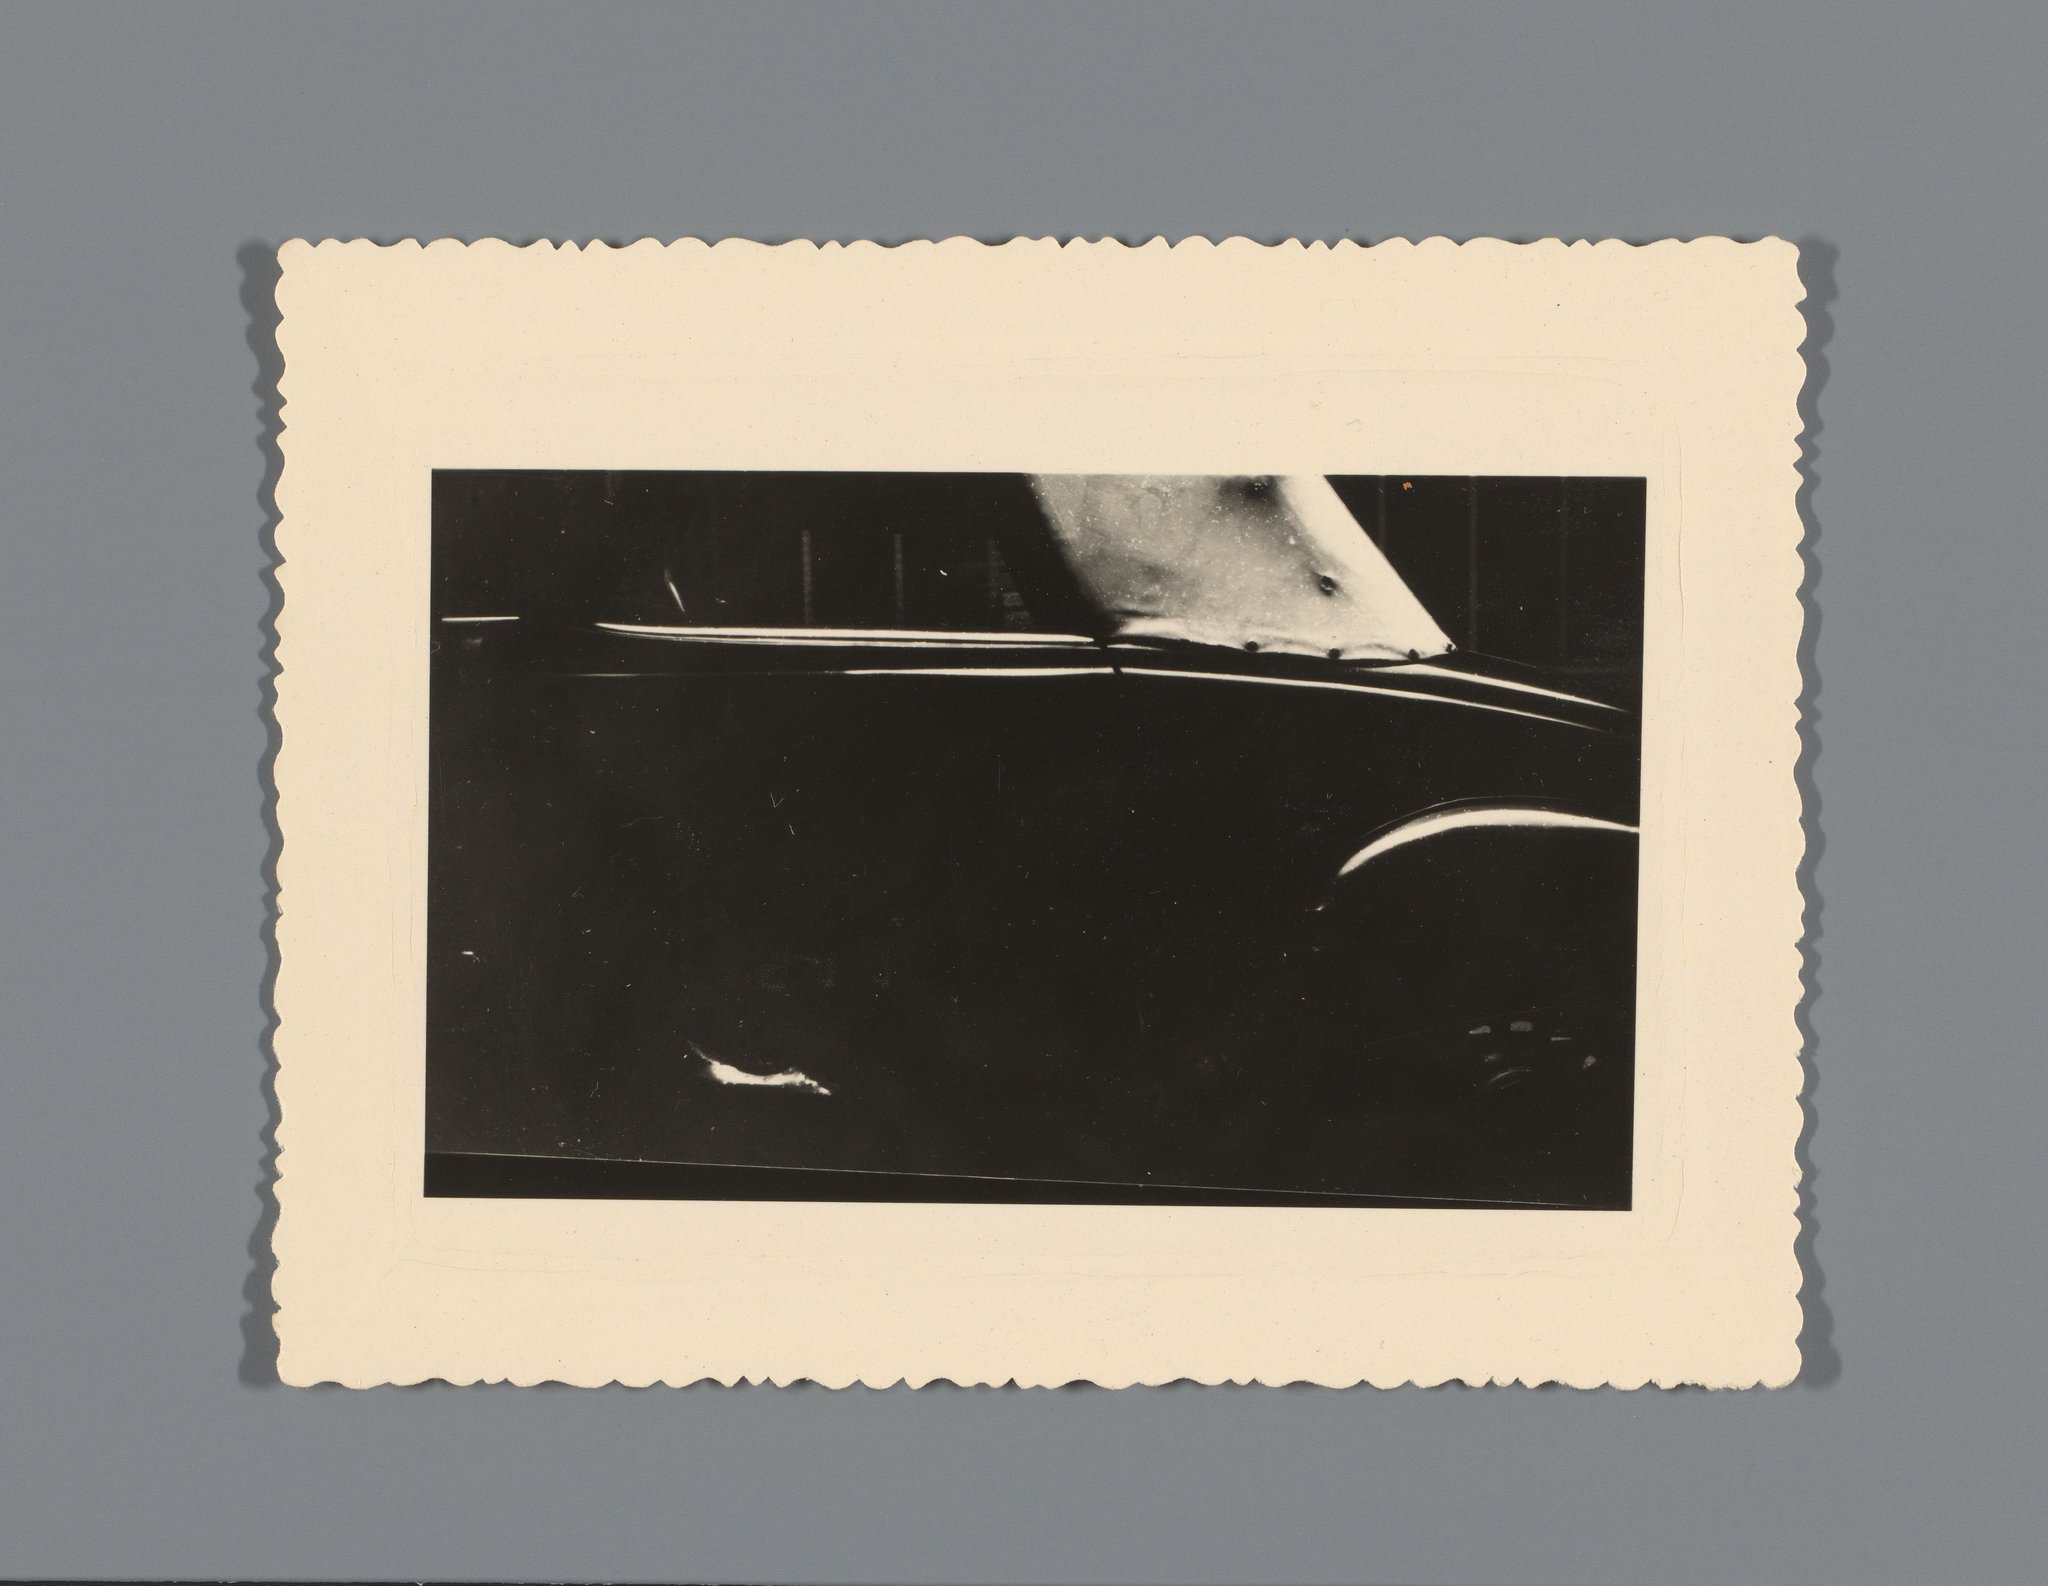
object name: photograph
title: Detail van een auto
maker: Anonymous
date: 1945-1960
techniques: gelatin silver print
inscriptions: stamp: ‘511’, inscription: ‘Gevaert / RIDAX’